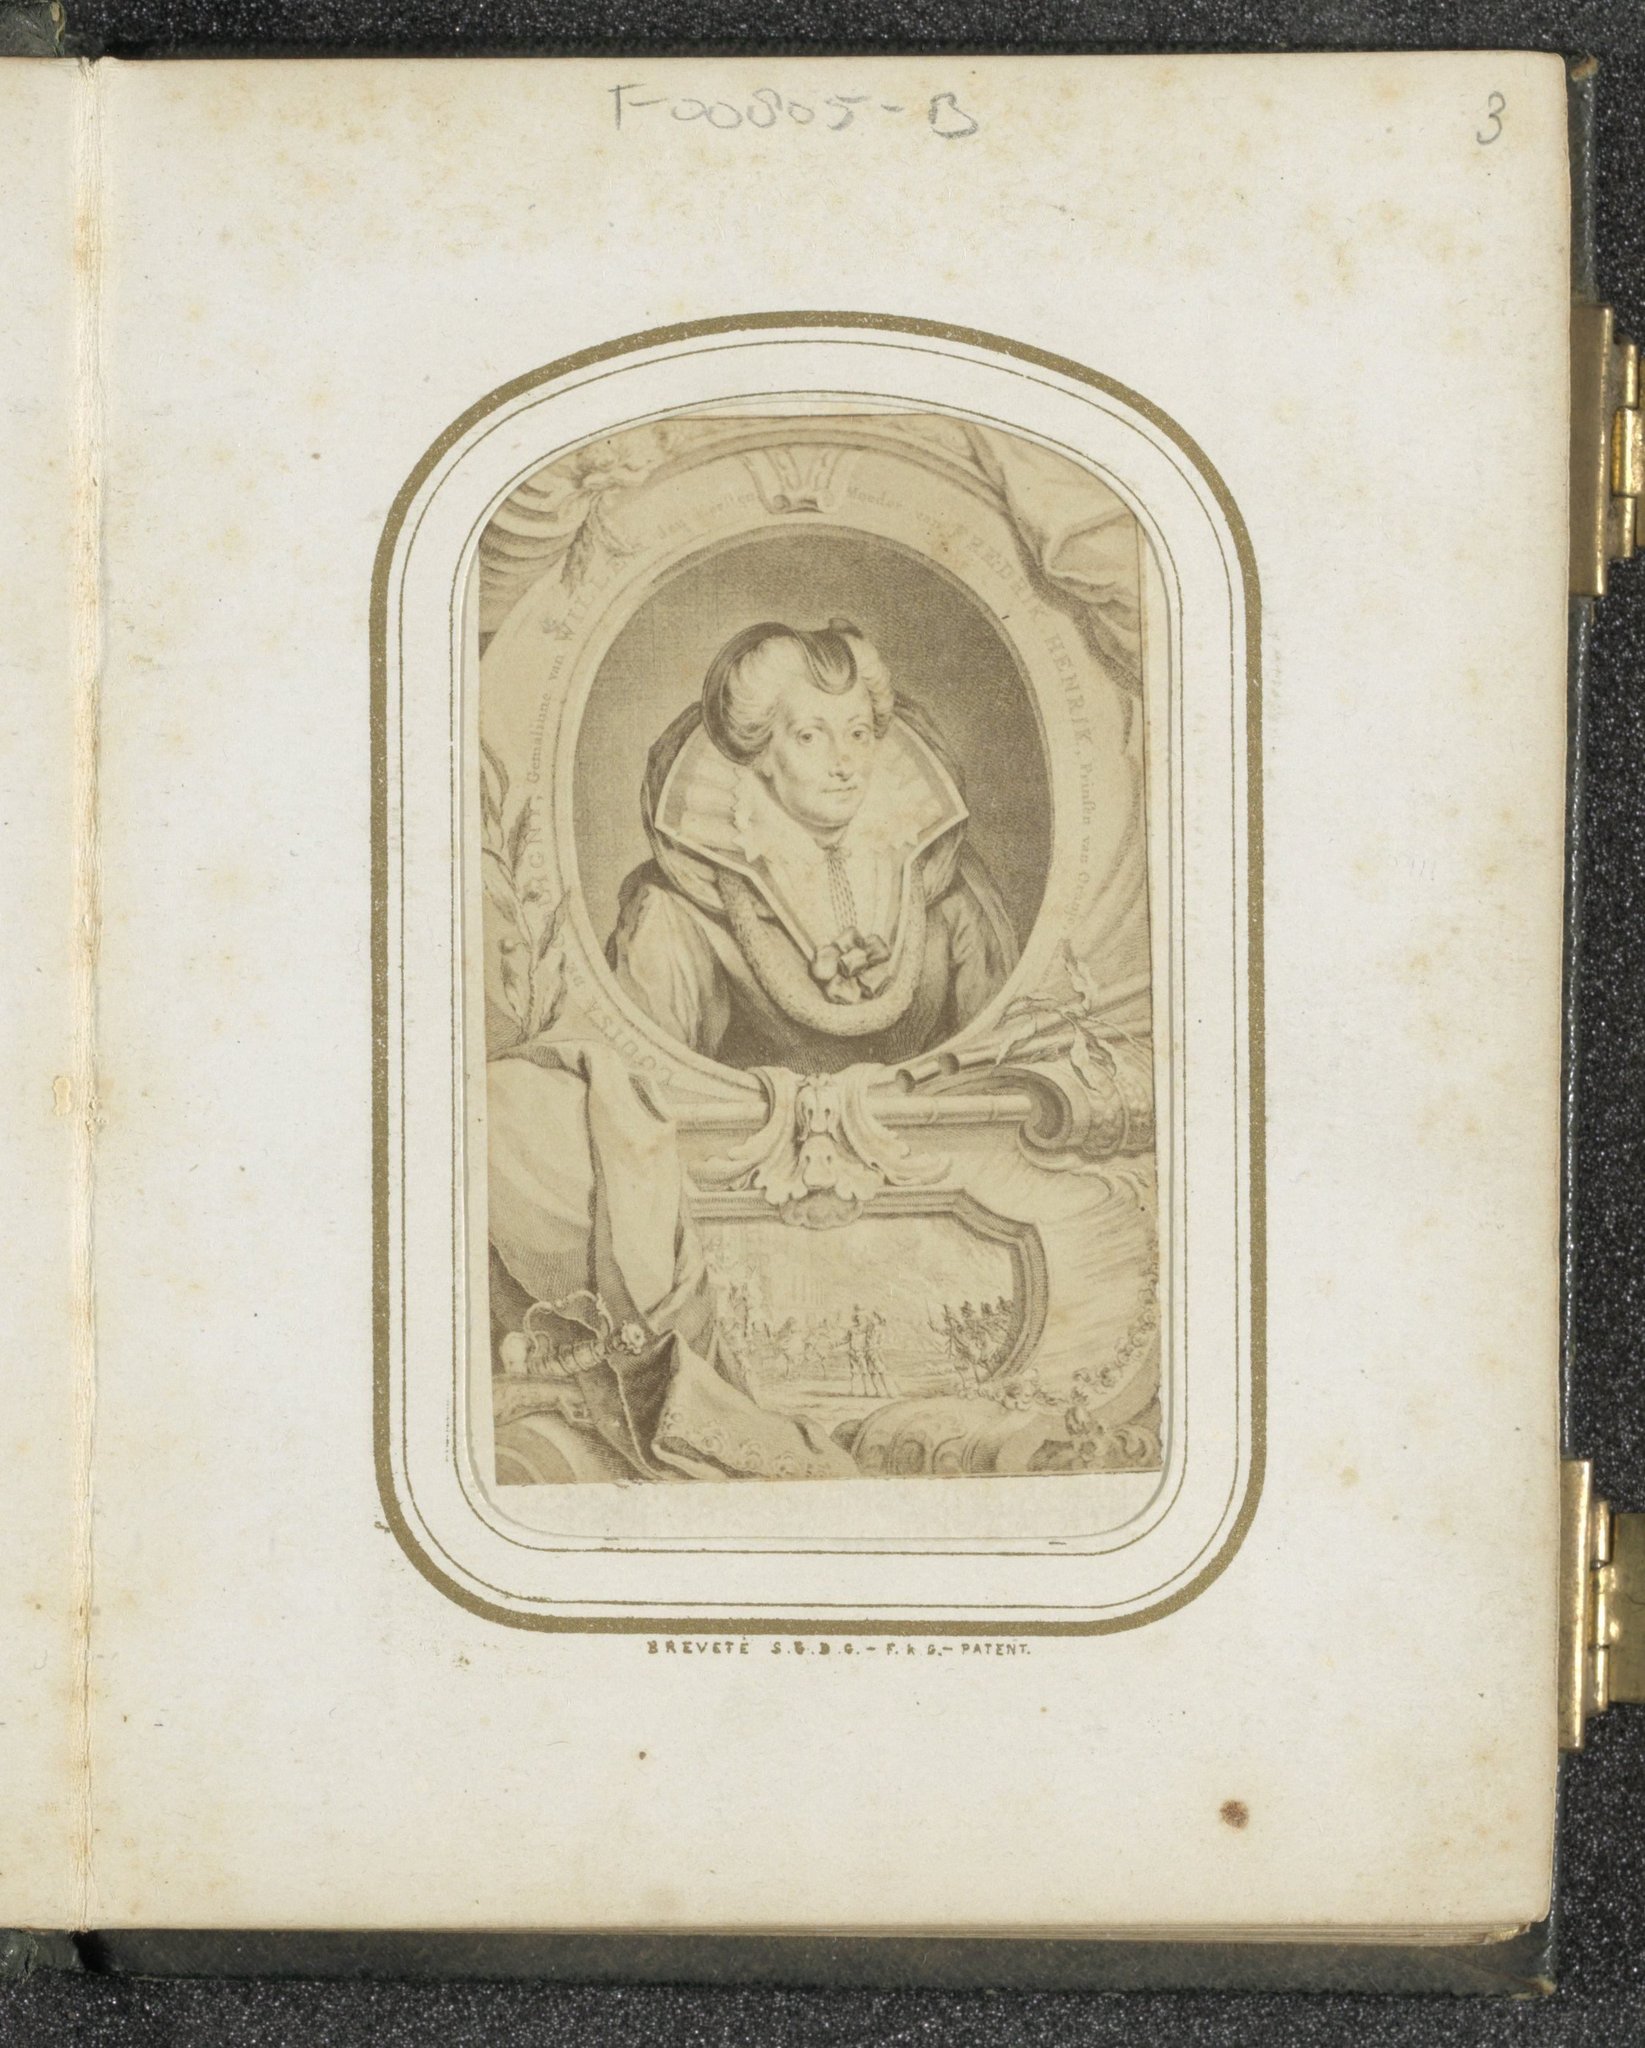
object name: carte de visite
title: Fotoreproductie van (vermoedelijk) een prent van Louise de Coligny, echtgenote van prins Willem I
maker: Anonymous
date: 1860-1880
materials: cardboard, paper, photographic support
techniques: albumen print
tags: louise de coligny, historical persons, styles of hairdress - aa - ~ women, clothing for the upper part of the body, neck-gear: collar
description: Onderdeel van Fotoalbum met 29 foto's van Nederlandse vorsten.